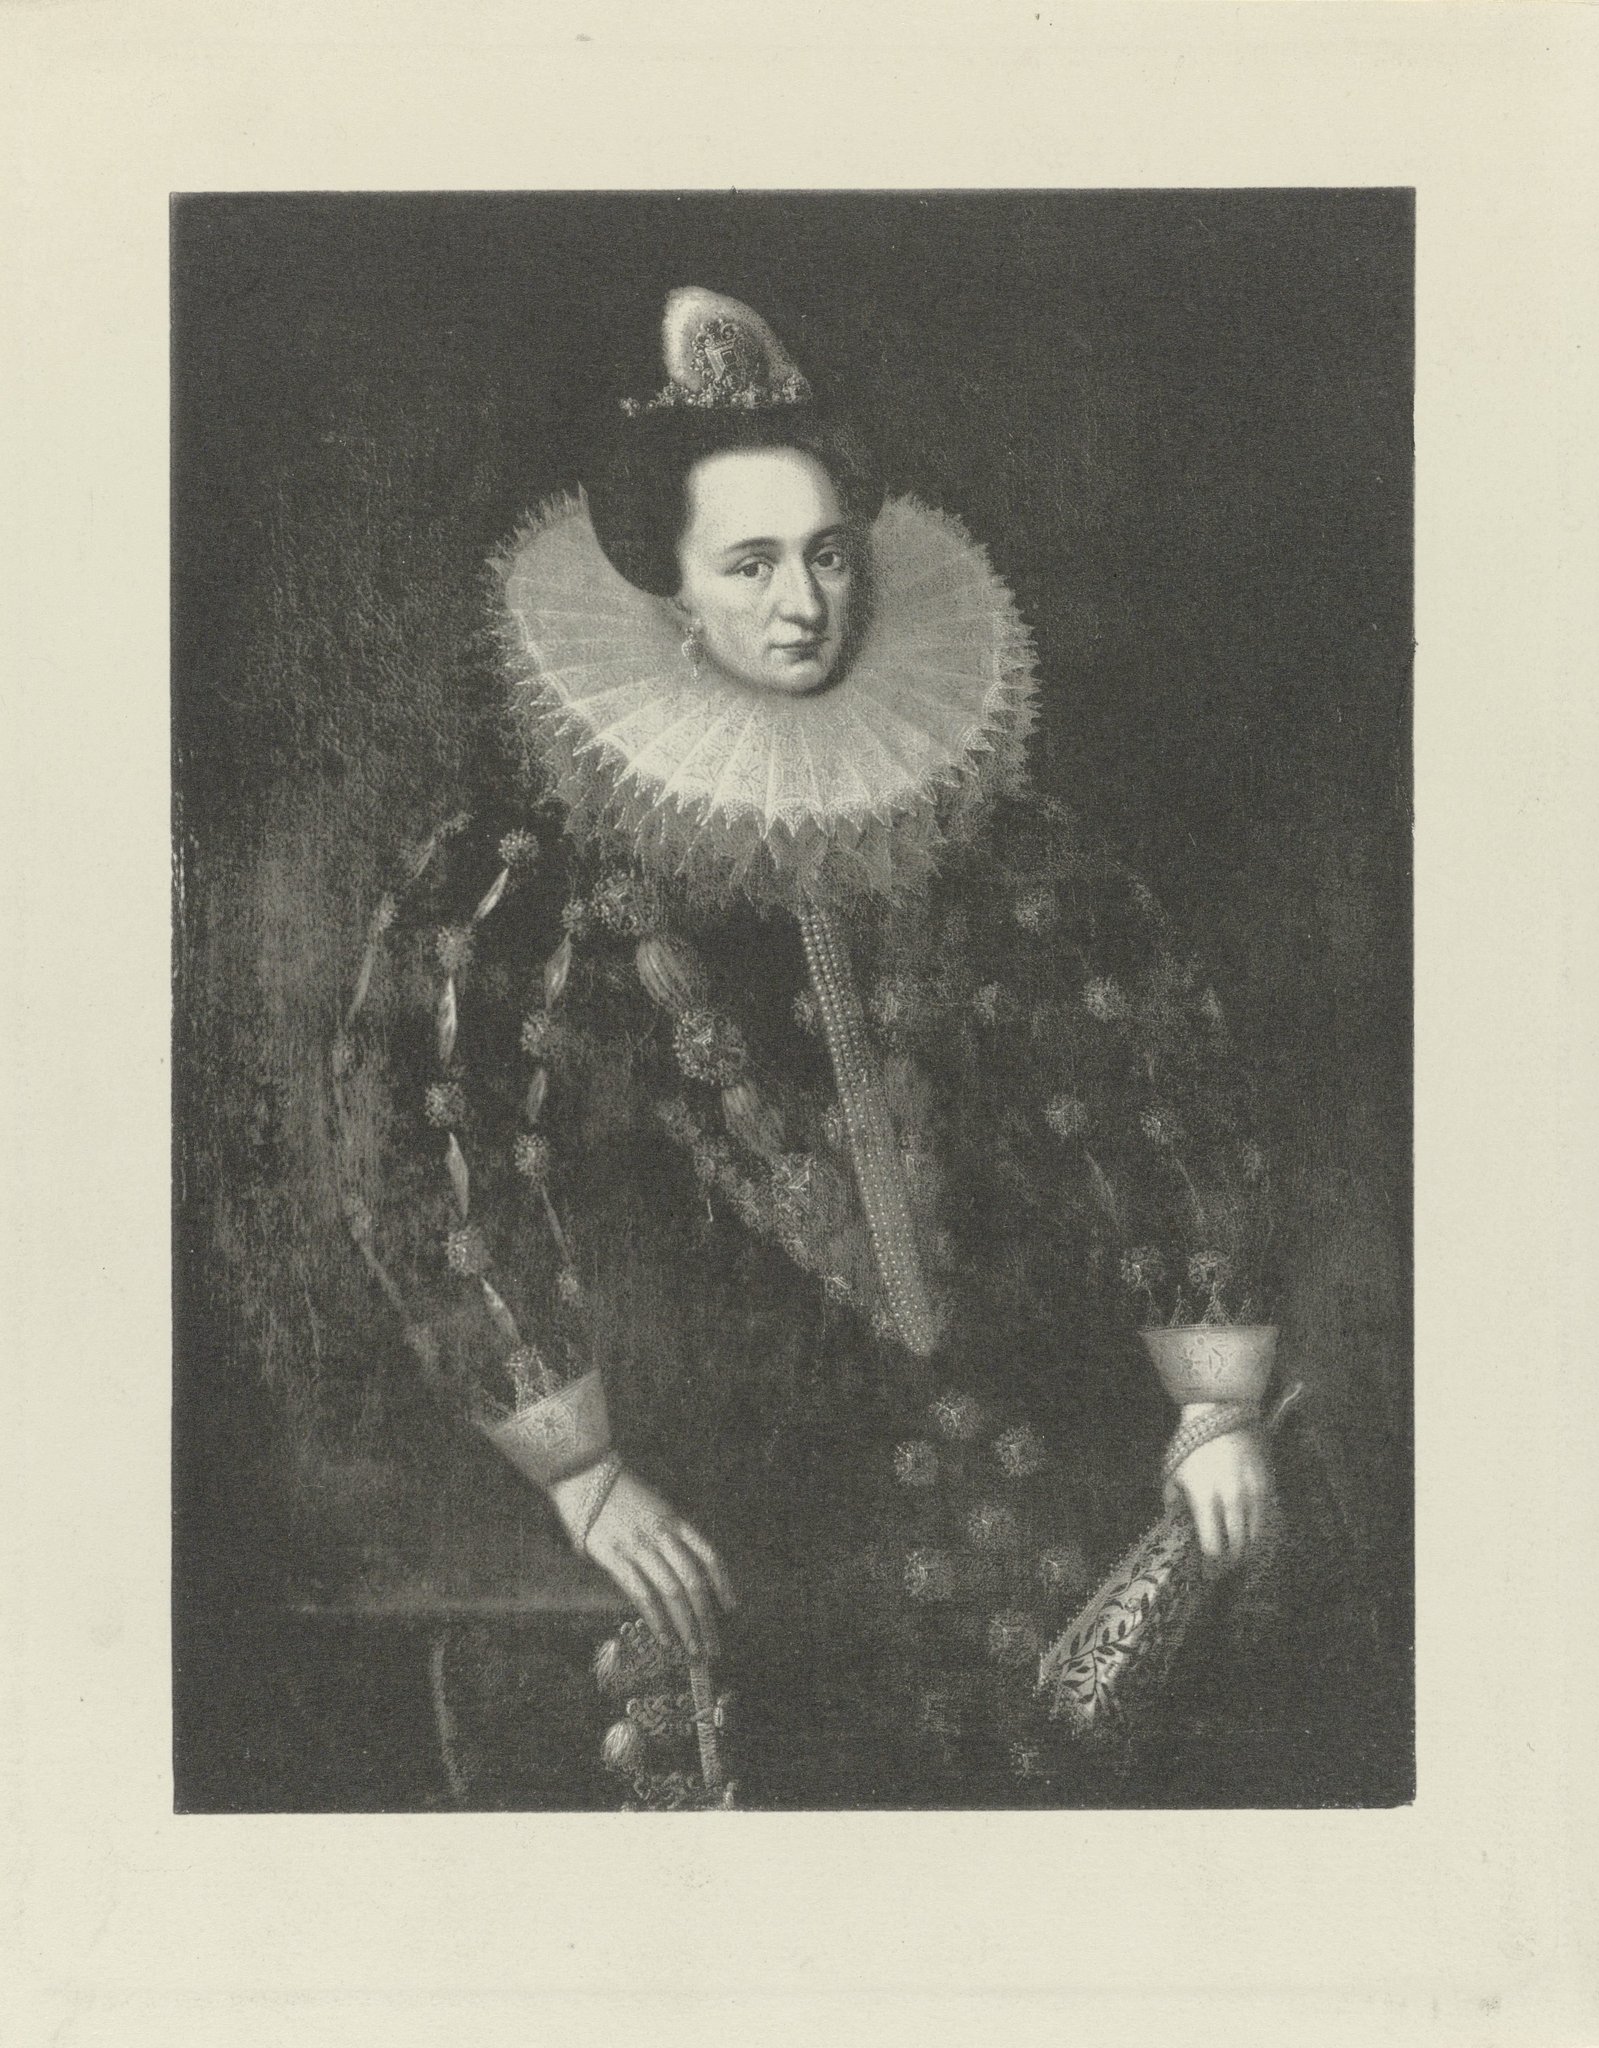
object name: photomechanical print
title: Portret van Maria, prinses van Oranje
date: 1850-1949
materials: paper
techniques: photochemical processes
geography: netherlands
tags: buren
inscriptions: collector's mark: Lugt 2228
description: De hier vermelde titel verwijst naar de hoogst verkregen titel van de geportretteerde, niet per se naar de titel die de geportretteerde op deze voorstelling draagt.